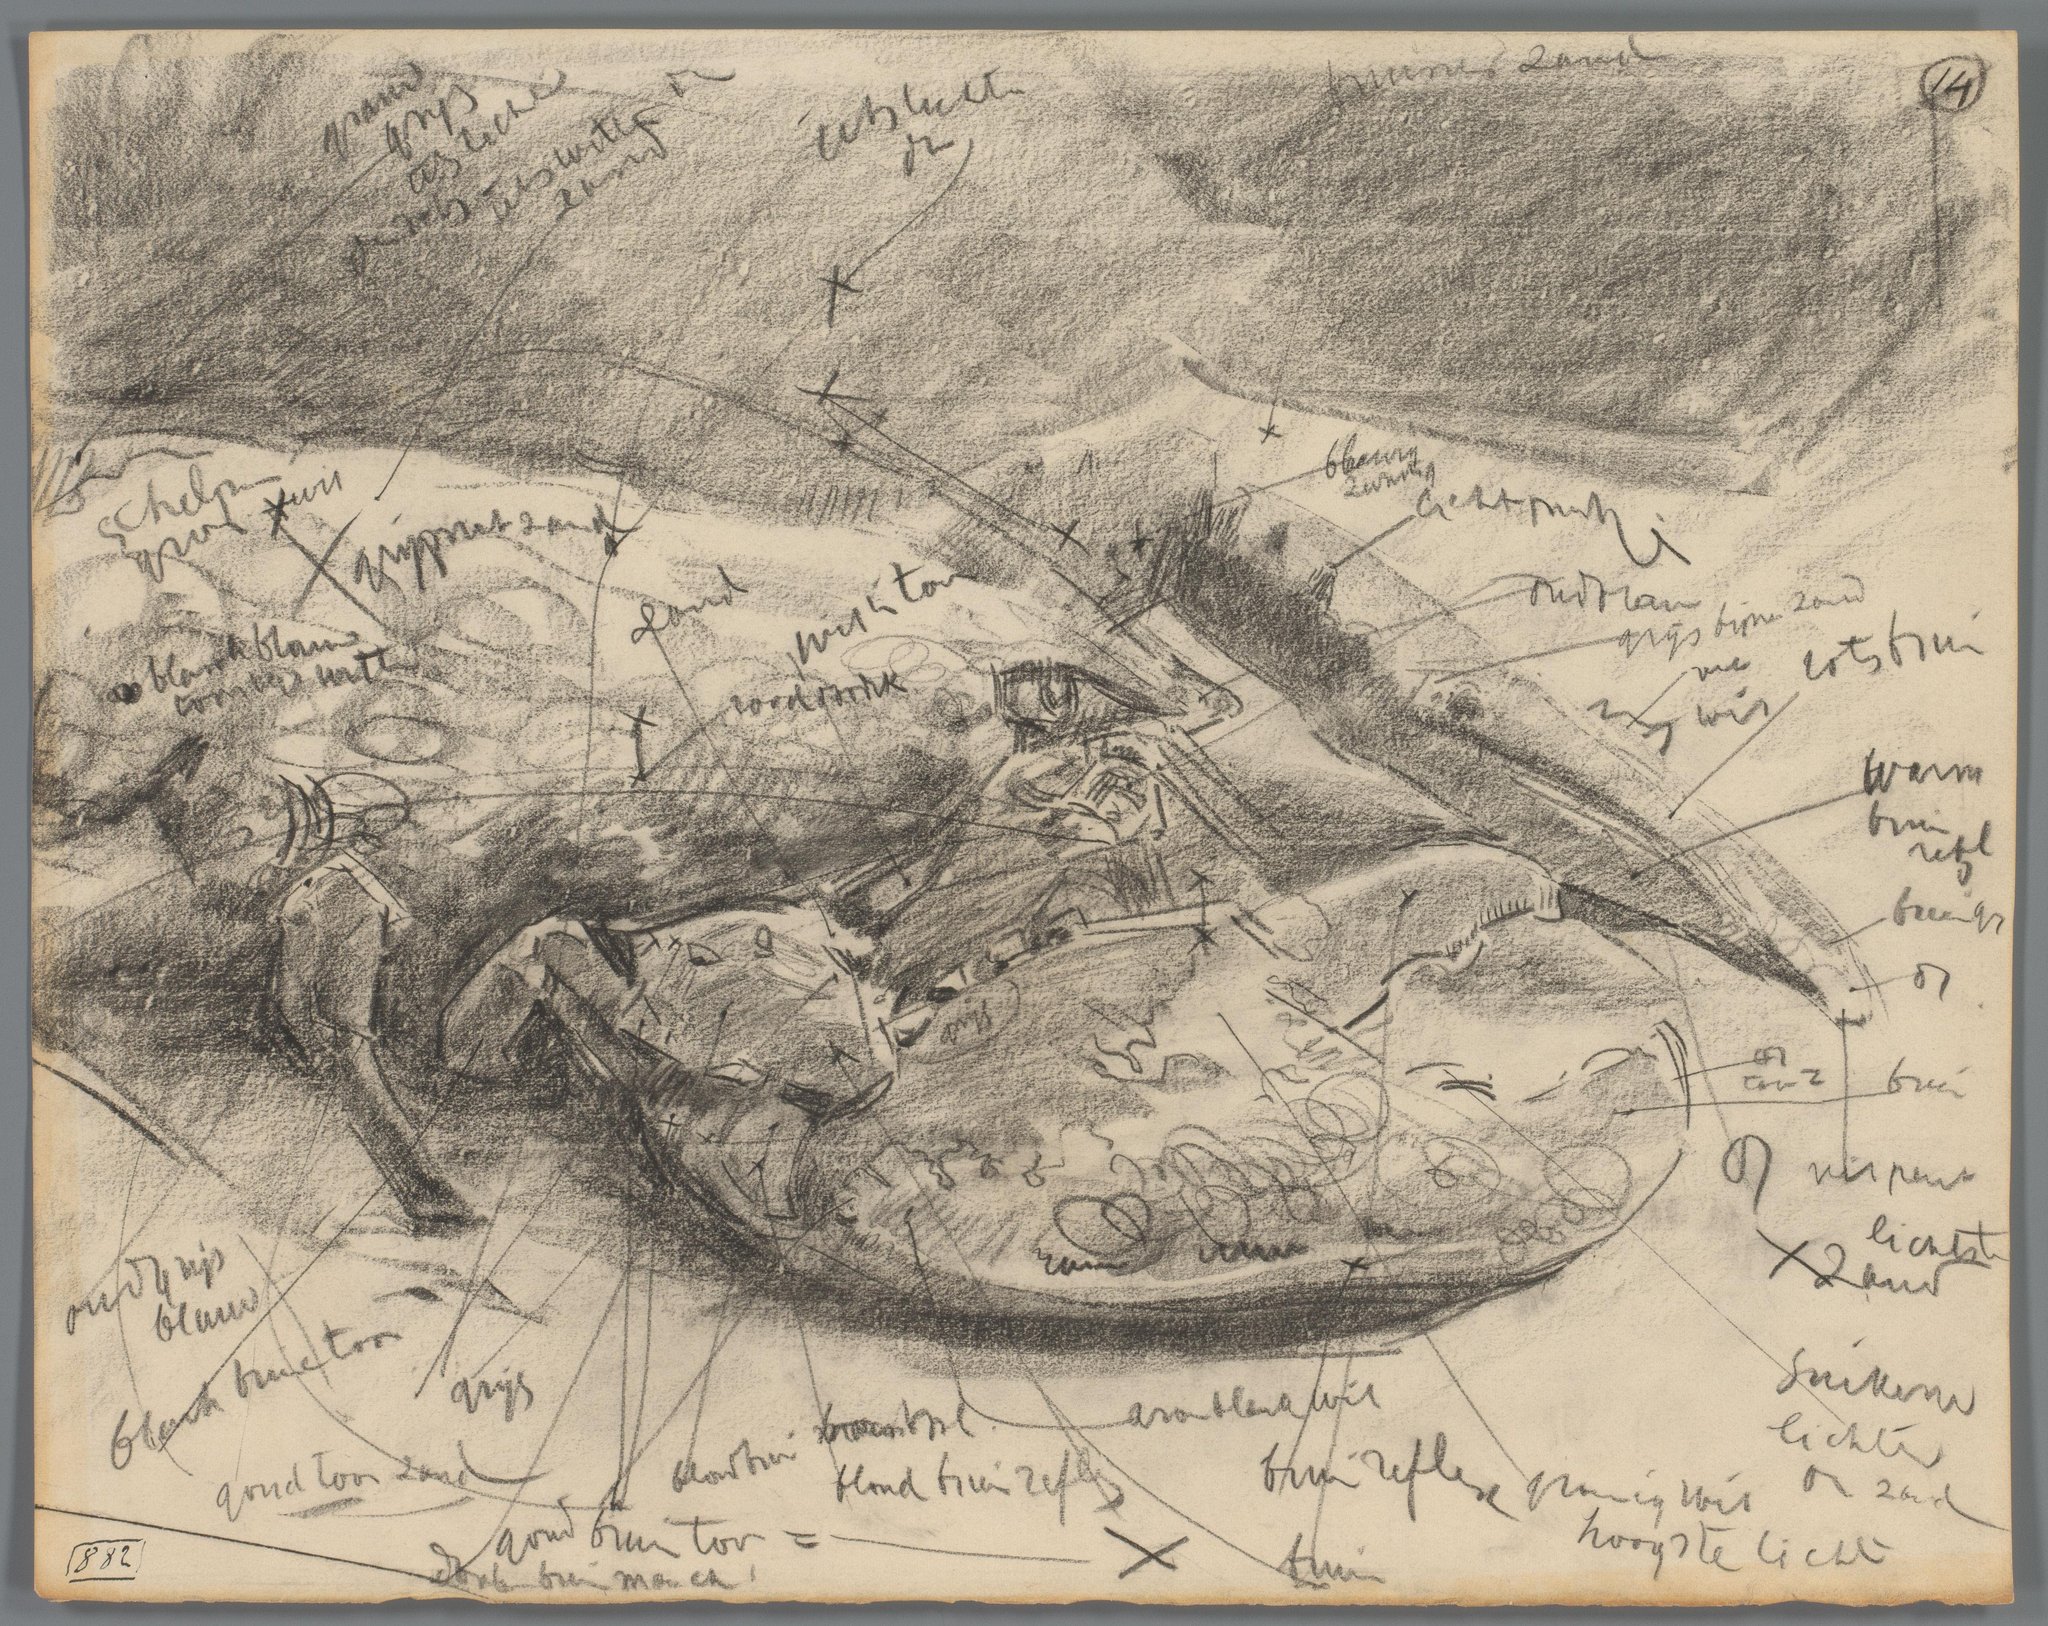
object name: drawing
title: Studie van het kopstuk en de scharen van een kreeft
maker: gerrit willem dijsselhof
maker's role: designer, draughtsman, print maker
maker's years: 1866-1924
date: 1876-1924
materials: chalk, paper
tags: crustaceans: lobster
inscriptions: number: ‘14’, number: ‘882’